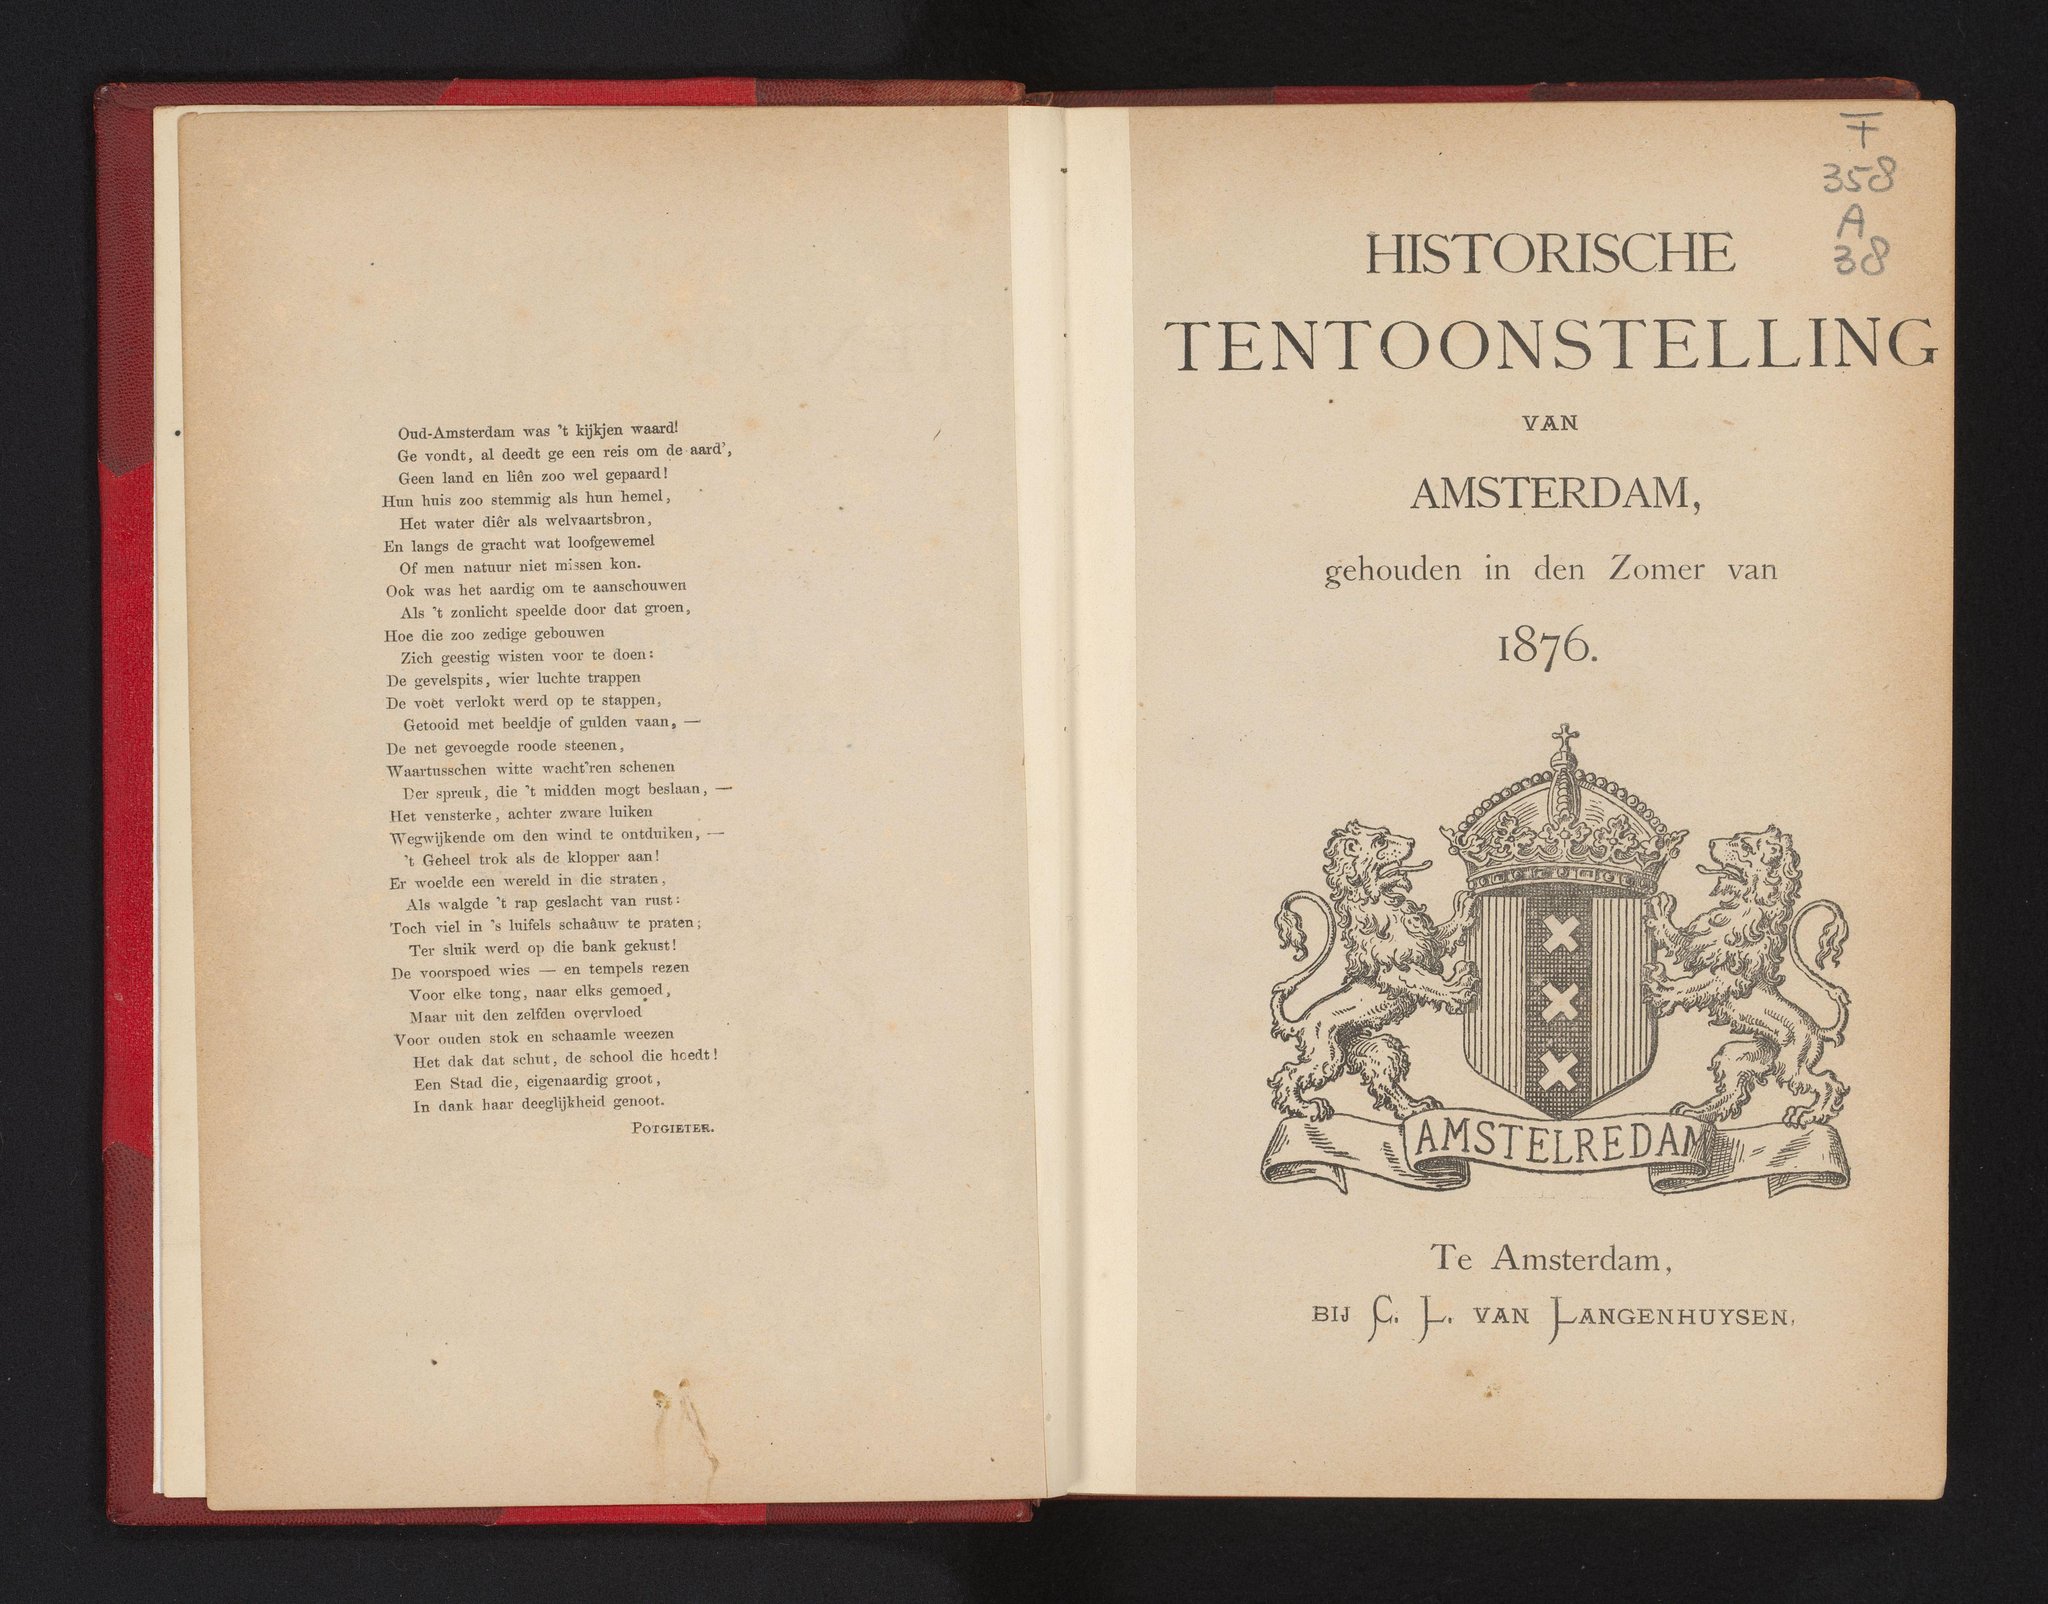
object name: book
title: Historische tentoonstelling van Amsterdam, gehouden in den zomer van 1876 / [red. D.C. Meijer jr. en P.H. Witkamp]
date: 1876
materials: cardboard, linen, paper, photographic support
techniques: albumen print, lithograph, printing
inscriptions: annotation: ‘MAY/ 1994’, annotation: ‘125,-’